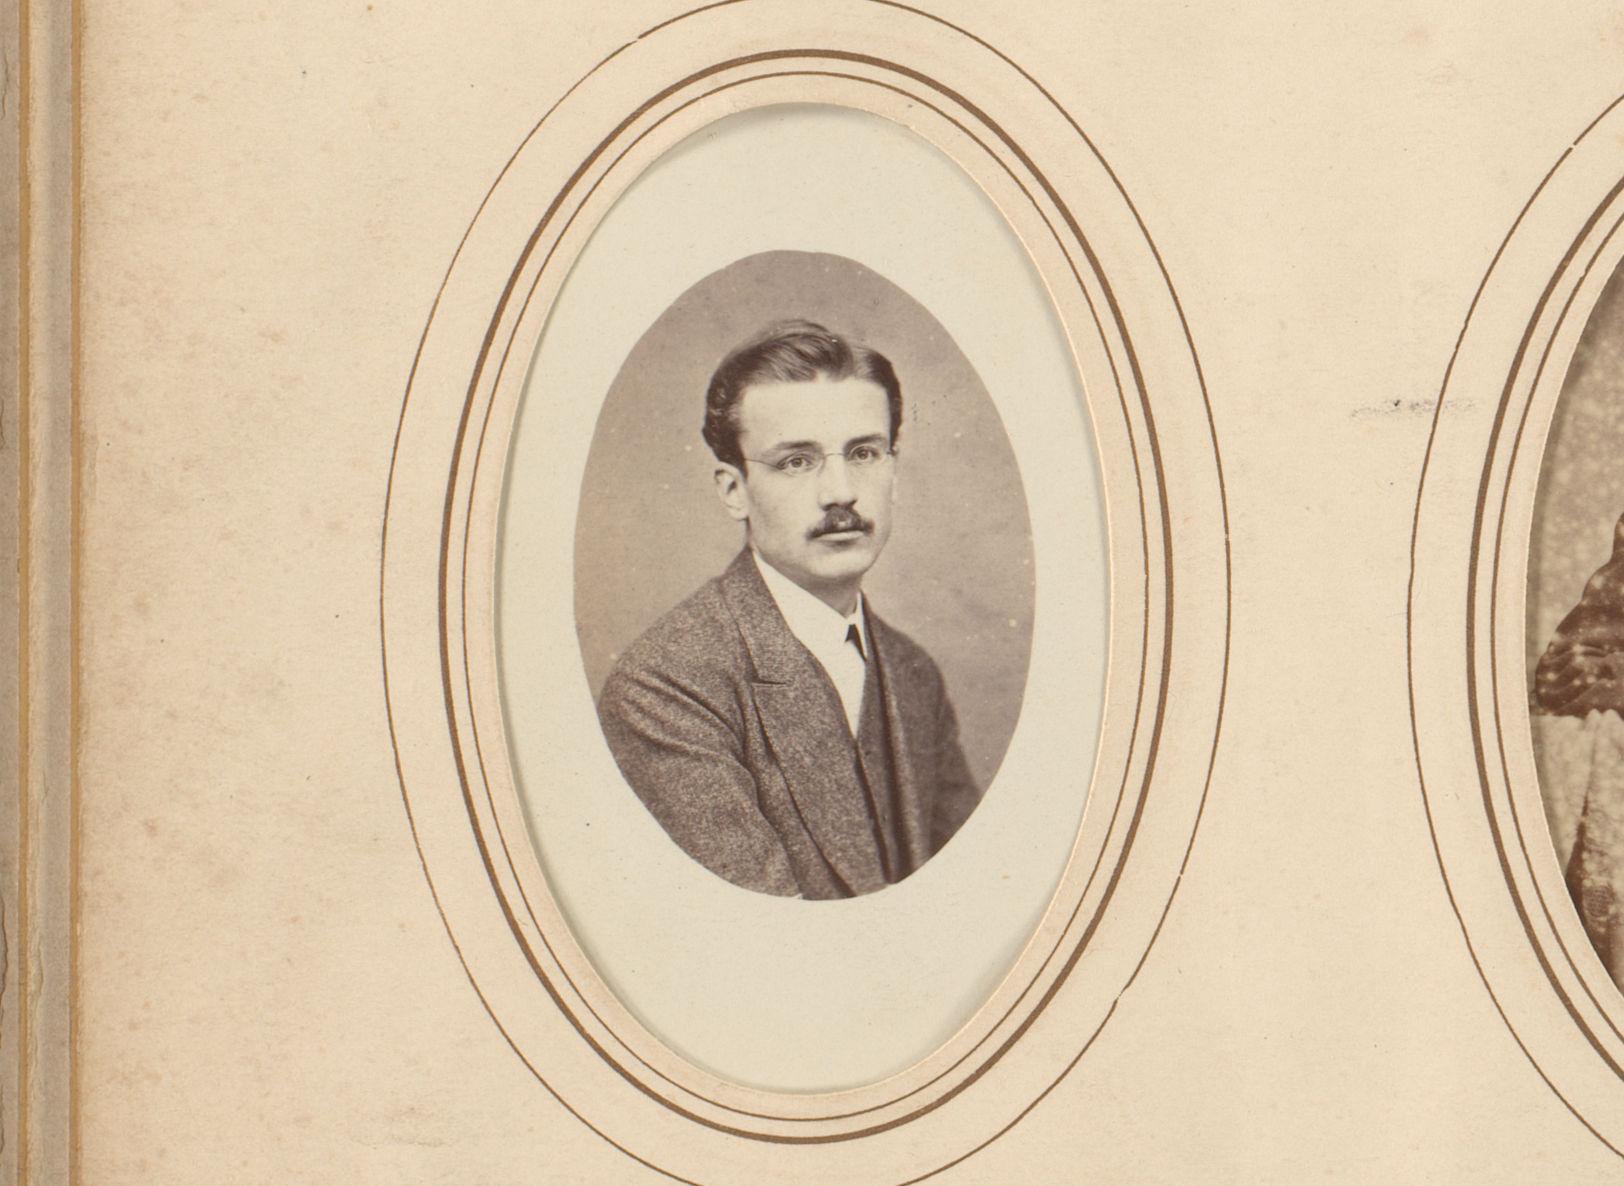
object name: carte de visite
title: Portret van onbekende man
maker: willem cornelis van dijk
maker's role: painter, print maker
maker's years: 1826-1881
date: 1870-1890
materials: cardboard, photographic support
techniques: albumen print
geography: utrecht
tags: adult man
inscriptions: inscription: ‘W.C. van Dijk/ Photographe / Utrecht / Langenieuwstraat / Lett.A.No.522.’